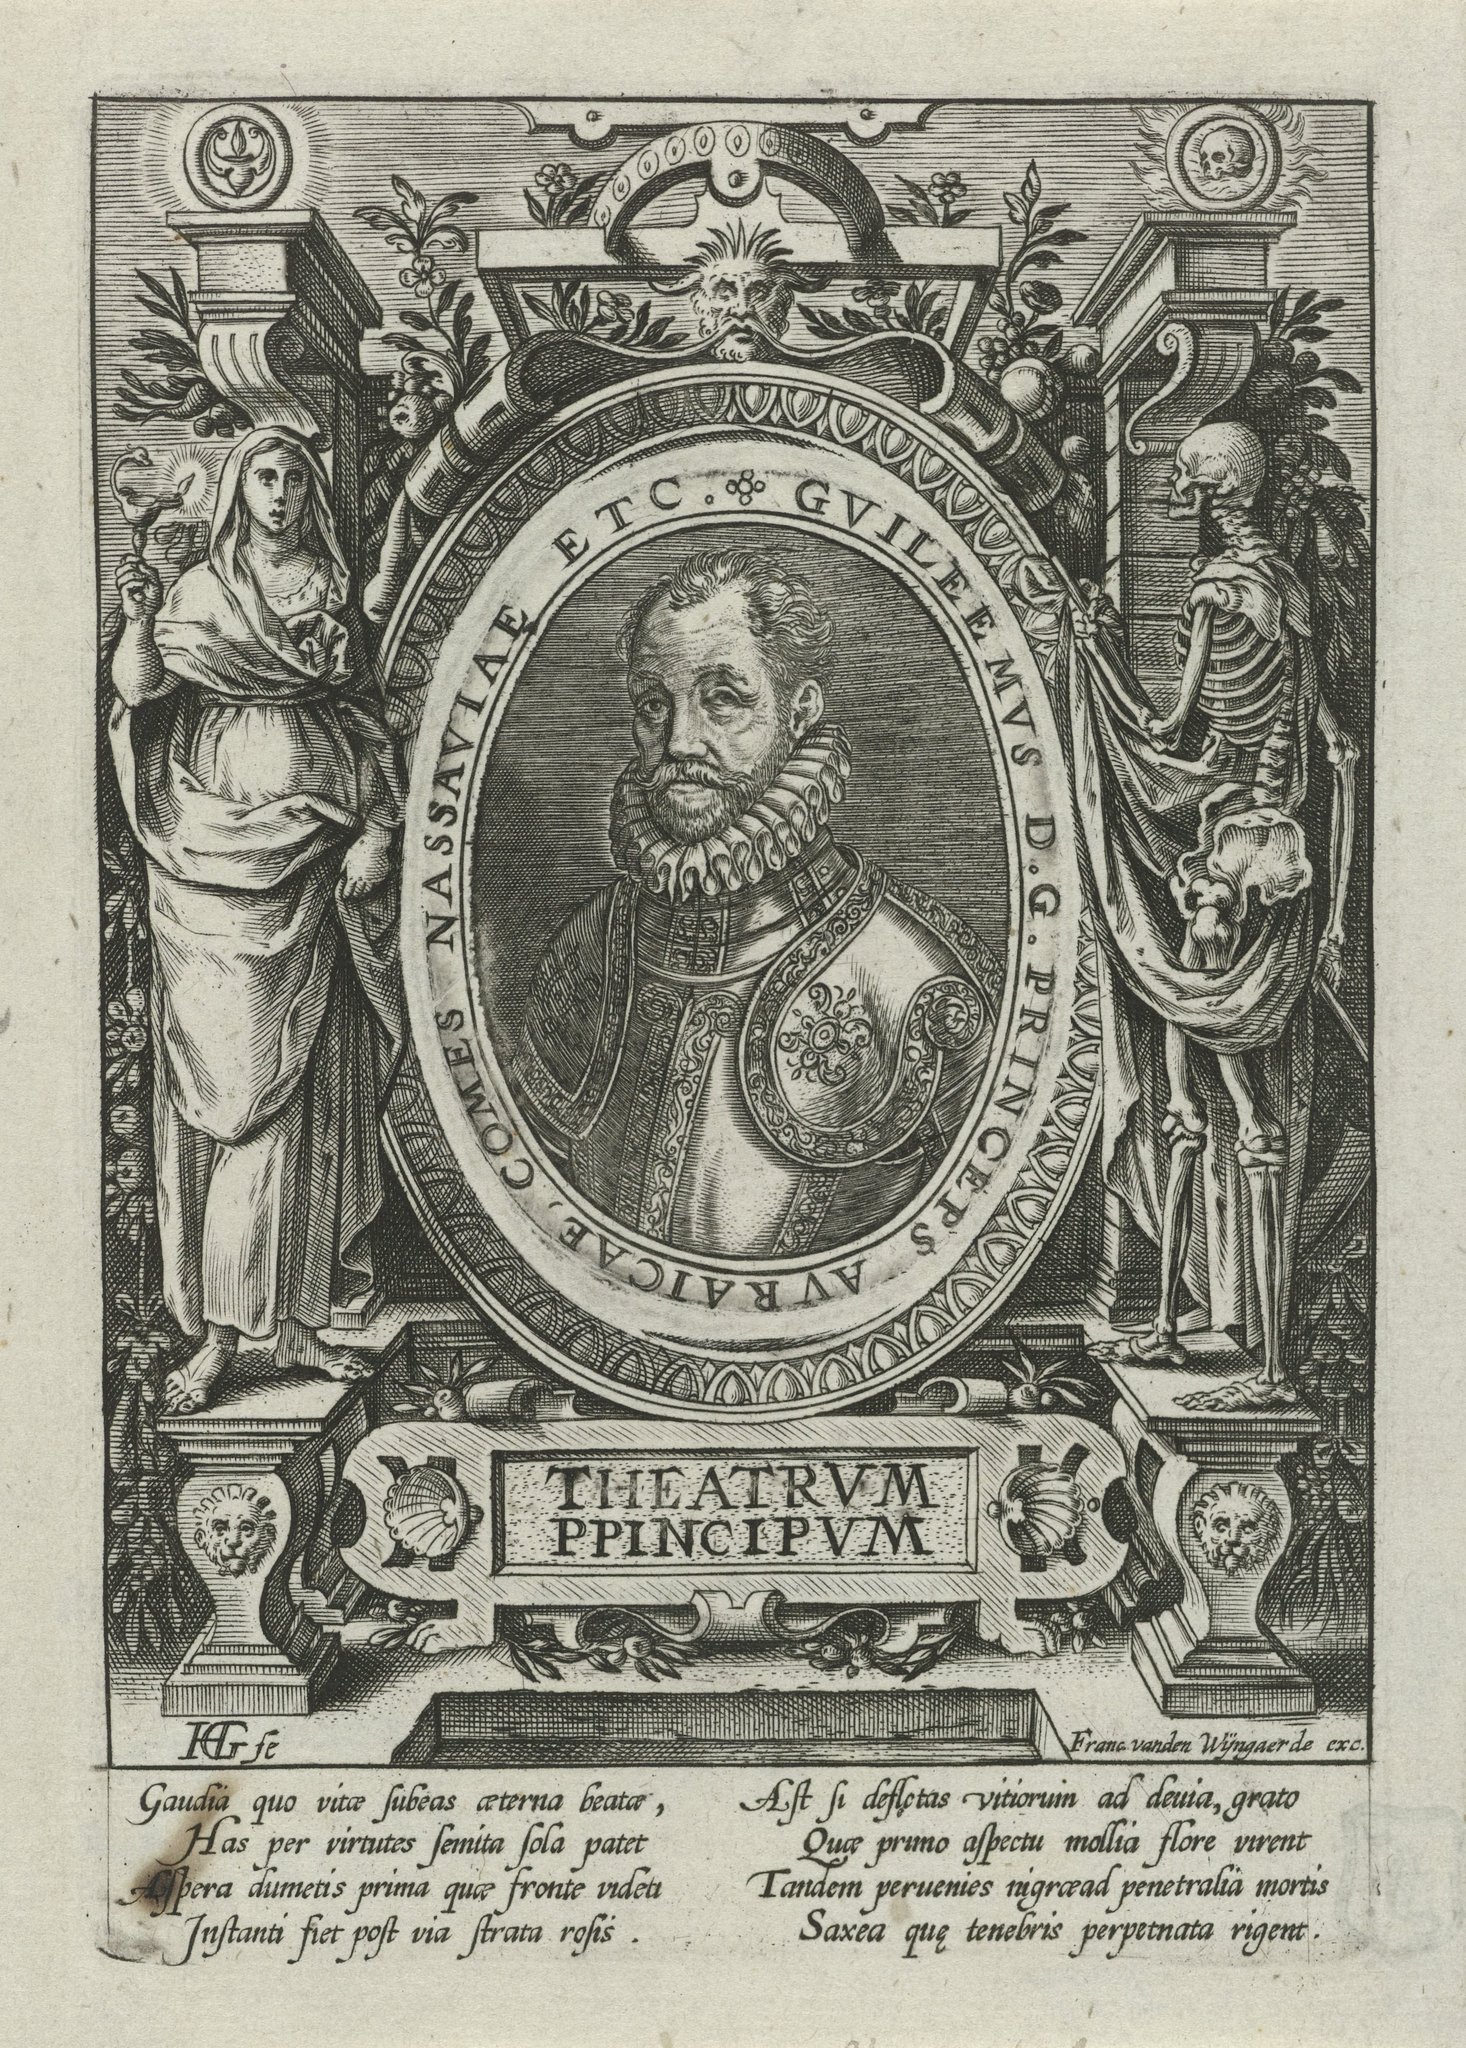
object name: print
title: Portret van Willem I, prins van Oranje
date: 1636-1679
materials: paper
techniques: engraving, etching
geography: low countries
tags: delft, william i (prince of orange)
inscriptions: collector's mark: Lugt 963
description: Portret van Willem I in een ovaal met randschrift. Geheel in een afzonderlijk gegraveerde omlijsting met een aantal allegorische objecten. In de ondermarge twee kolommen met elk vier regels Latijnse tekst.